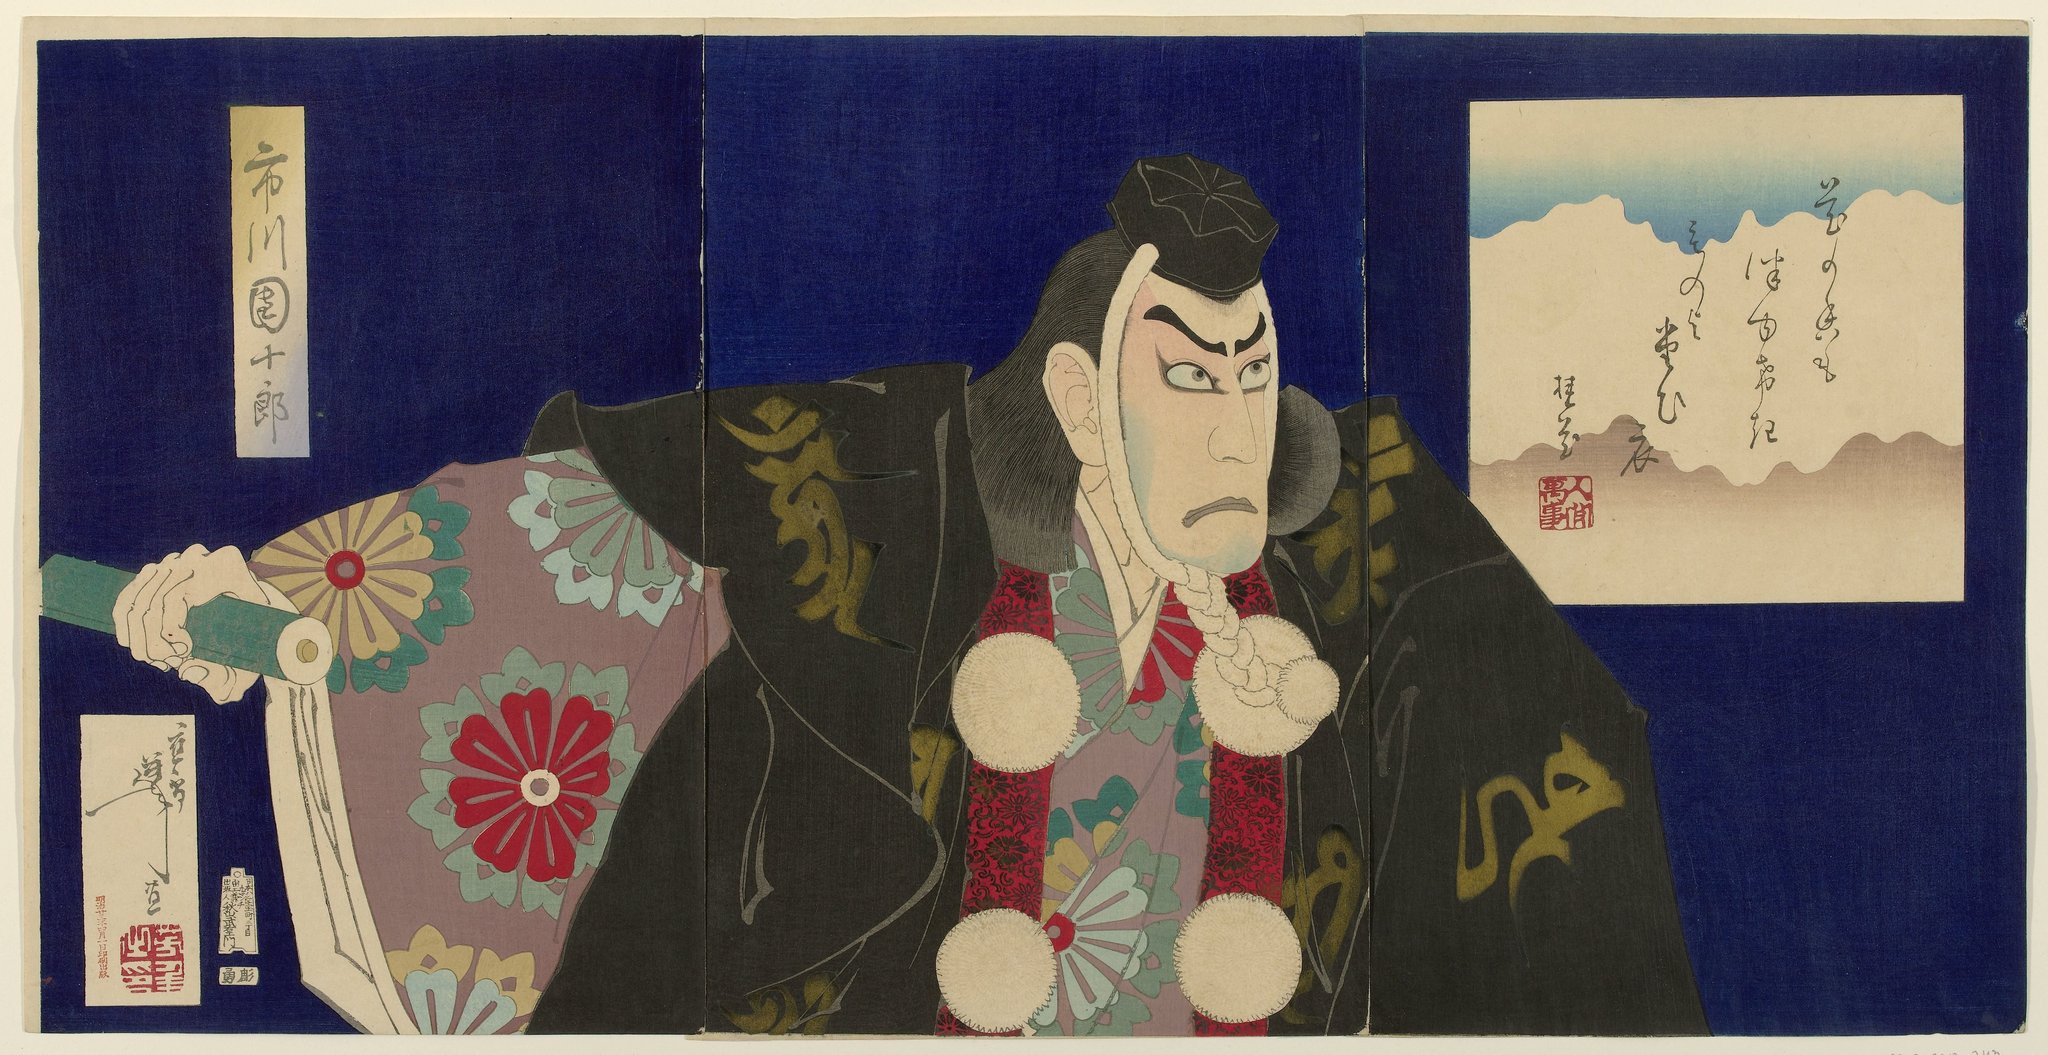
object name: print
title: Ichikawa Danjuro IX als Benkei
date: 1890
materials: gold powder, paper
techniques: blind stamped, woodcut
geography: tokyo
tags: portrait of actor, actress, actor (on the stage)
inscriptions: date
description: De acteur Ichikawa Danjuro IX, ten halven lijve, met rol in rechter hand, als Musashibo Benkei in het kabuki stuk Kanjincho; tegen donker blauwe achtergrond.